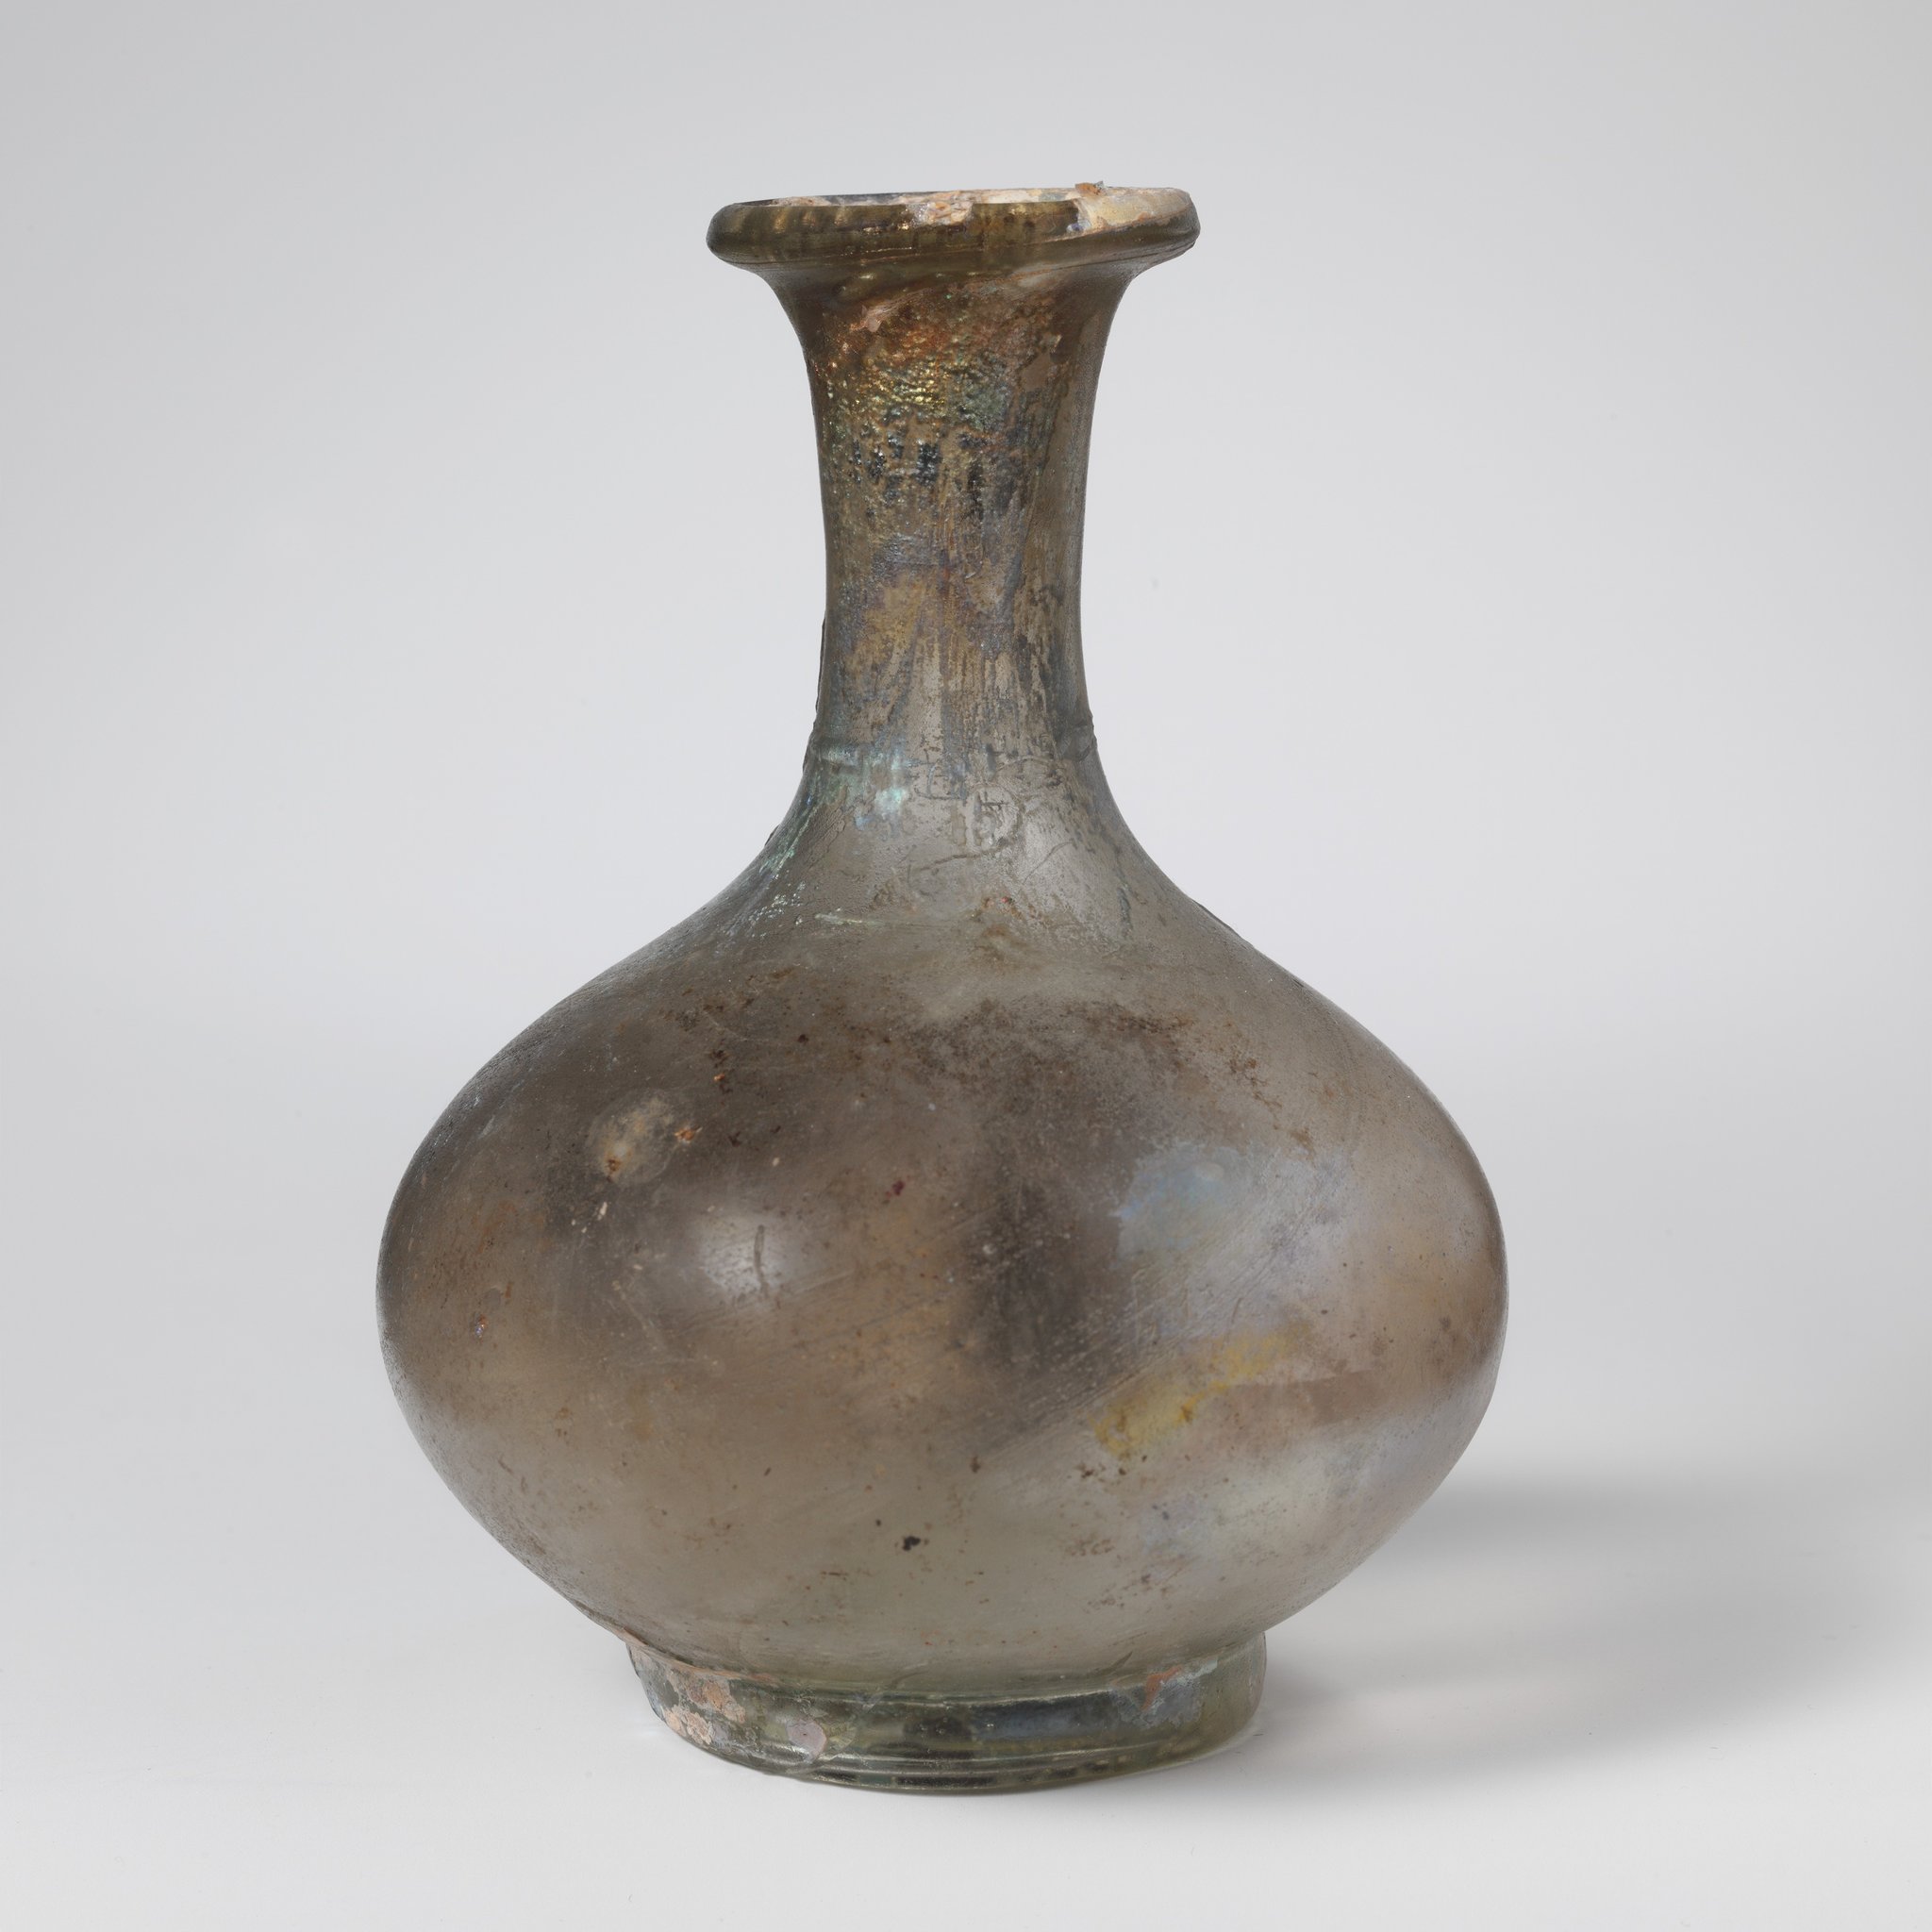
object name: flask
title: Glass flask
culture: roman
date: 101-300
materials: glass